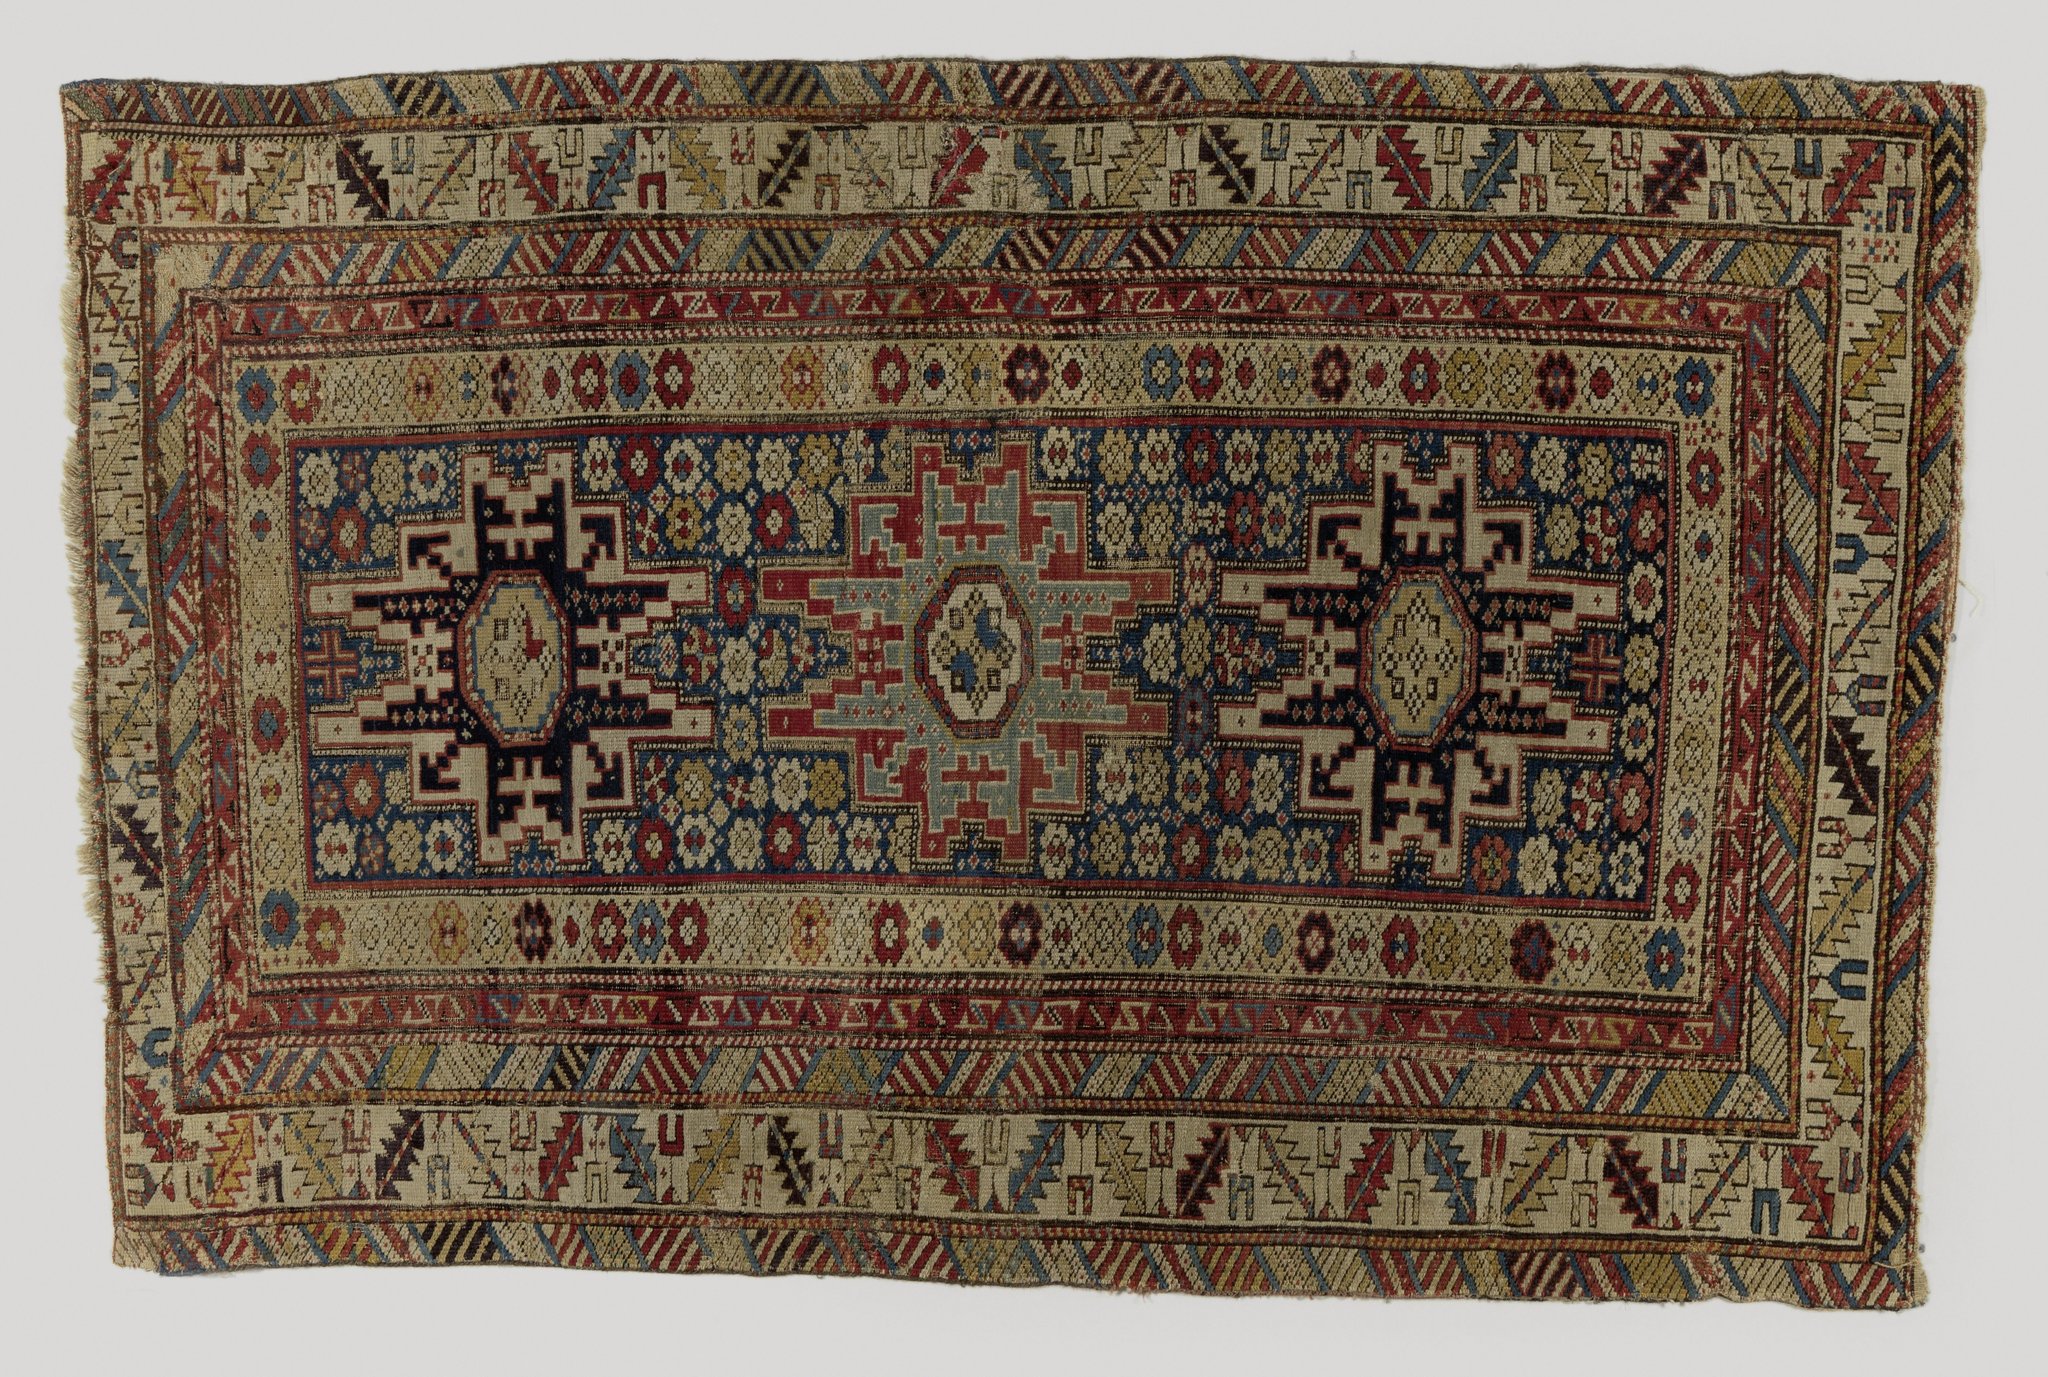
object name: oriental rug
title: Oosters tapijt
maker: Anonymous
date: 1800-1850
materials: wool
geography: cuba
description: Oosters tapijt, stermedaillonkleed. In het middenveld drie stermedaillons en veldvulling van rozetbloemen tegen een kobaltblauwe achtergrond. Vijfvoudige rand met geometrische motieven.